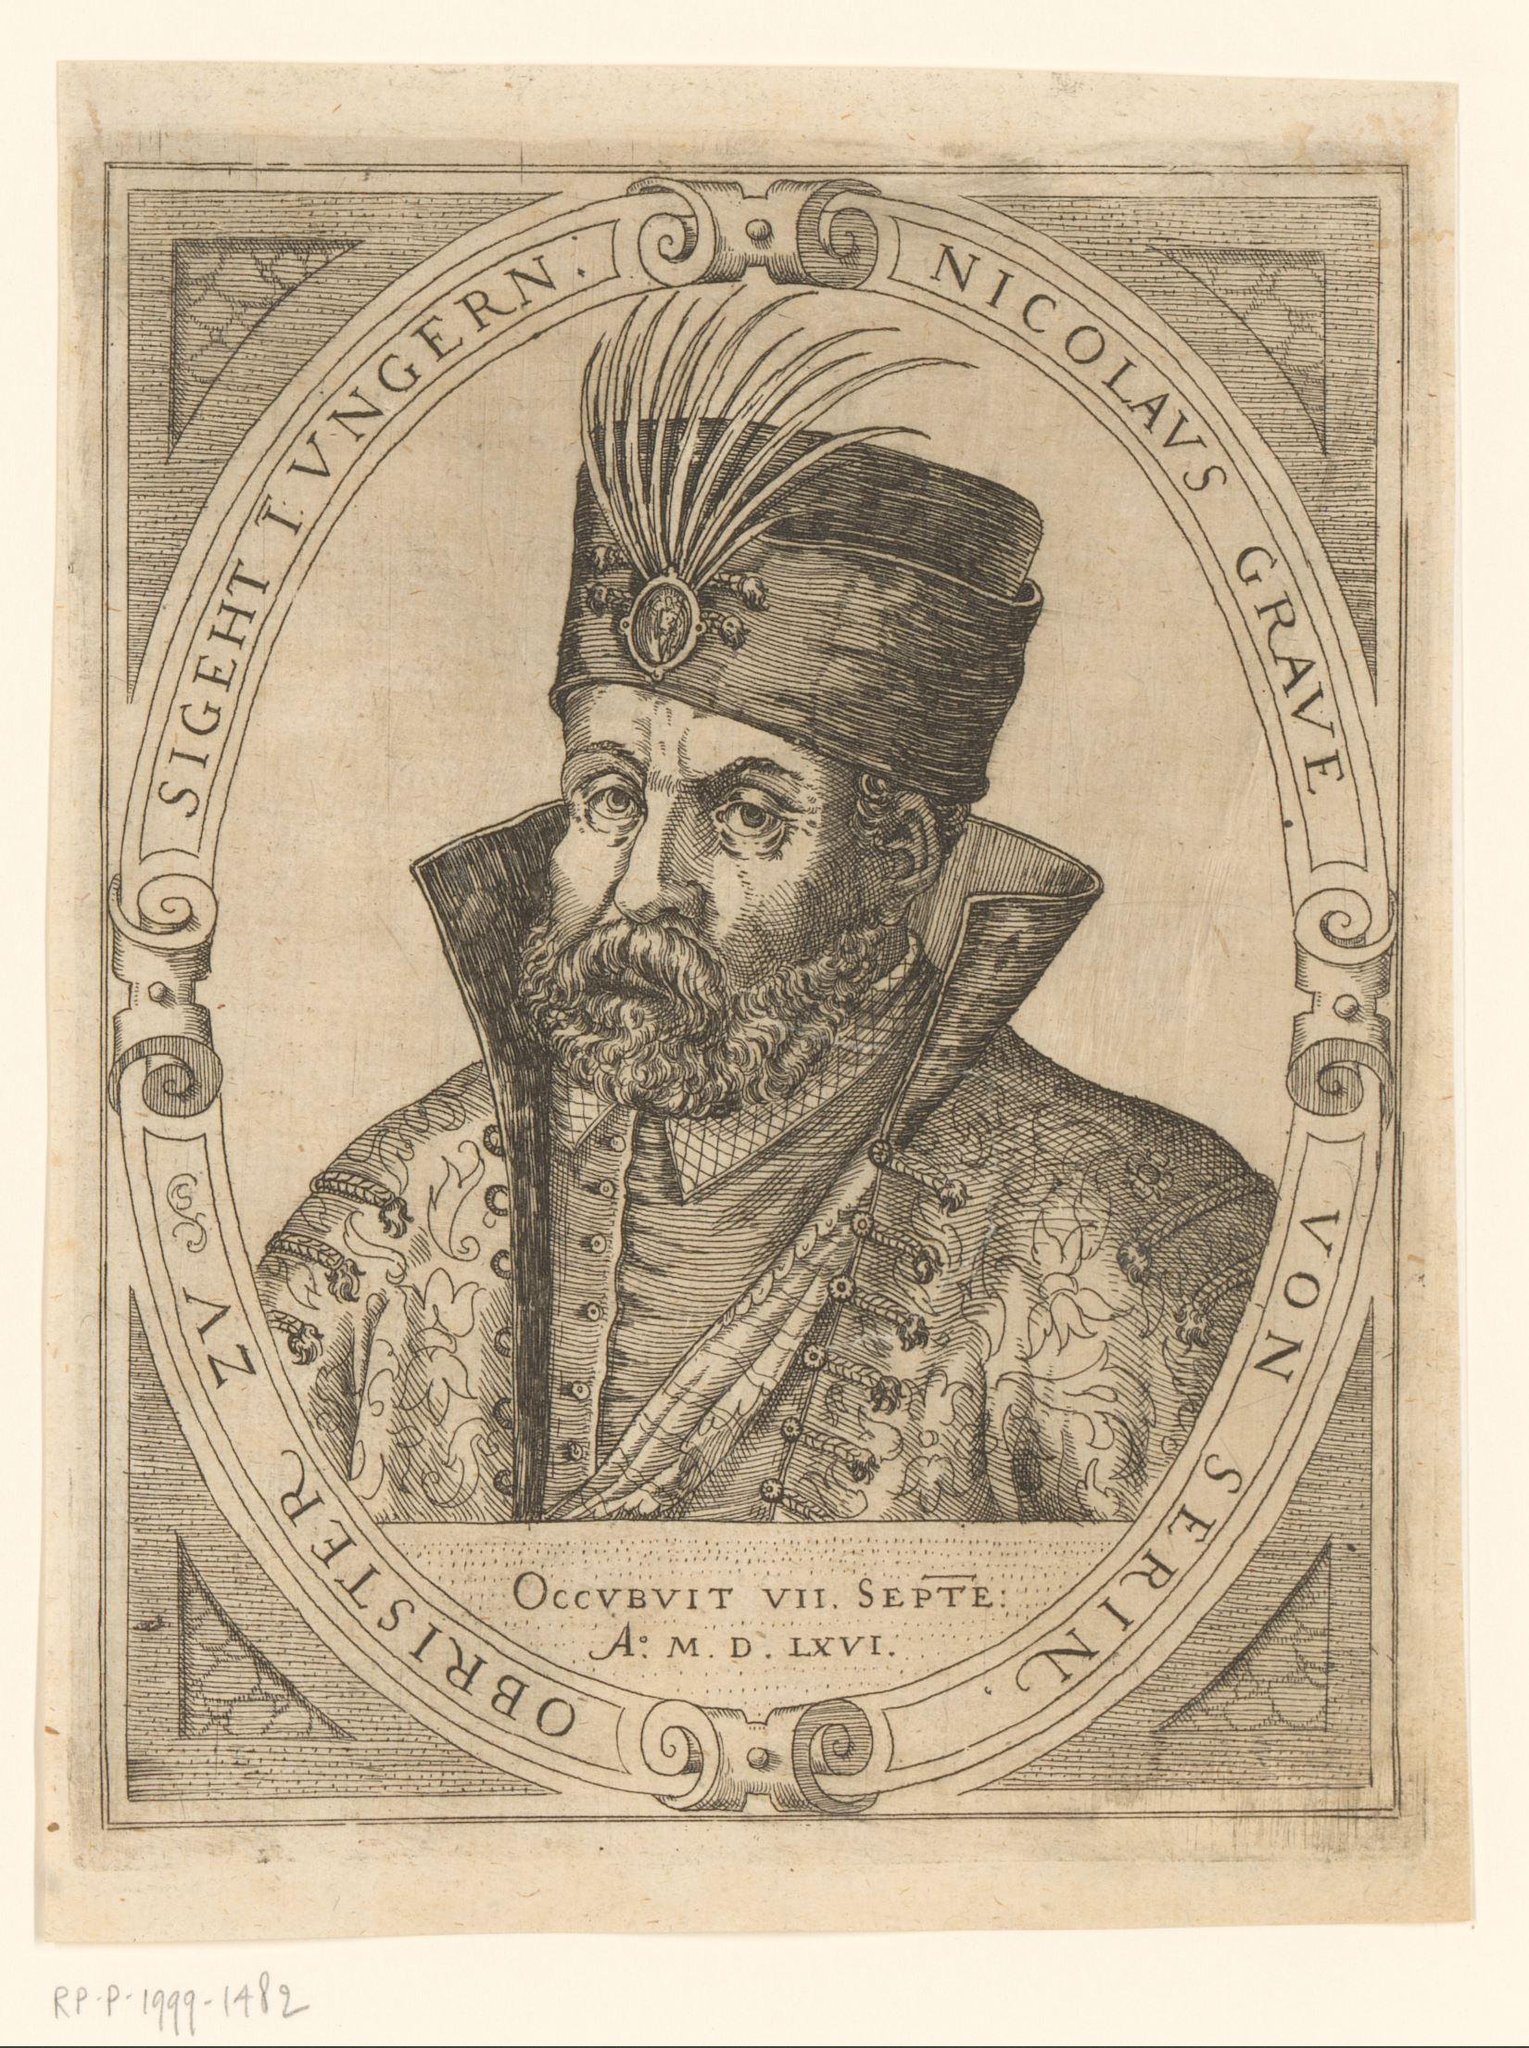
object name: print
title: Portret van Nikola Zrinski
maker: hans sibmacher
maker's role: print maker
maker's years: -1611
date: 1590-1611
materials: paper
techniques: etching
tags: historical persons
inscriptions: collector's mark: Lugt 2228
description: Prent ook gebruikt in: Oretlius, Hieronymus. Chronologica (...). Neurenberg: Valentin Fuhrmann et. al., 1602-1665.